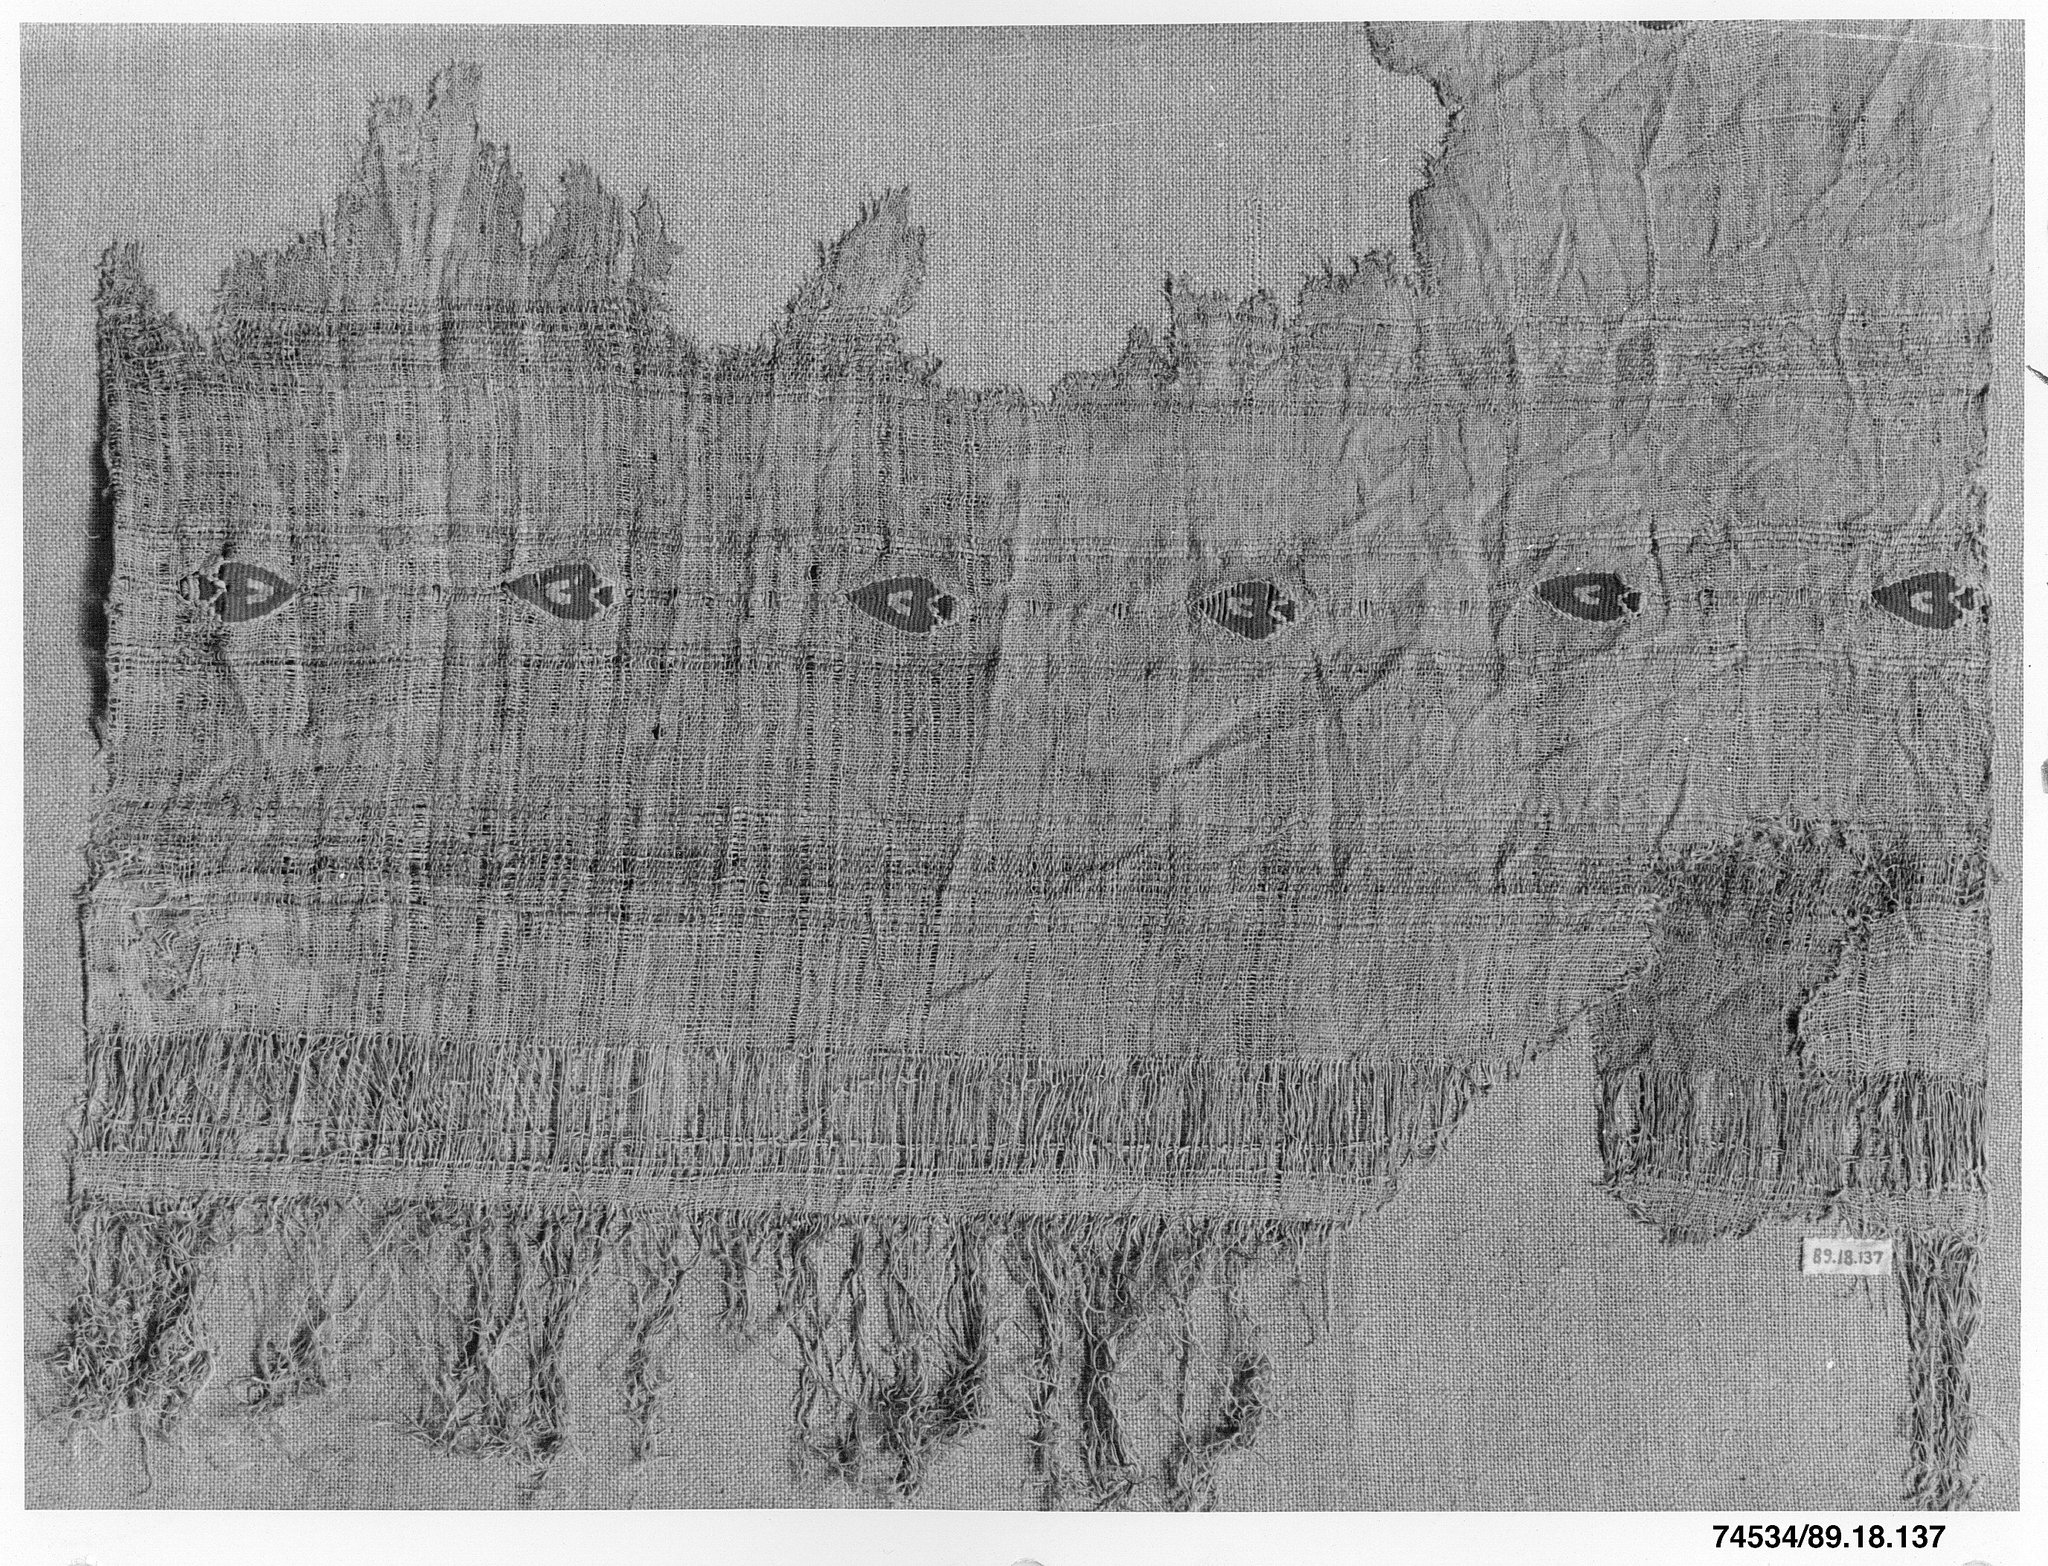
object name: textile fragment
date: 401-600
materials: linen, wool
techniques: weave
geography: egypt